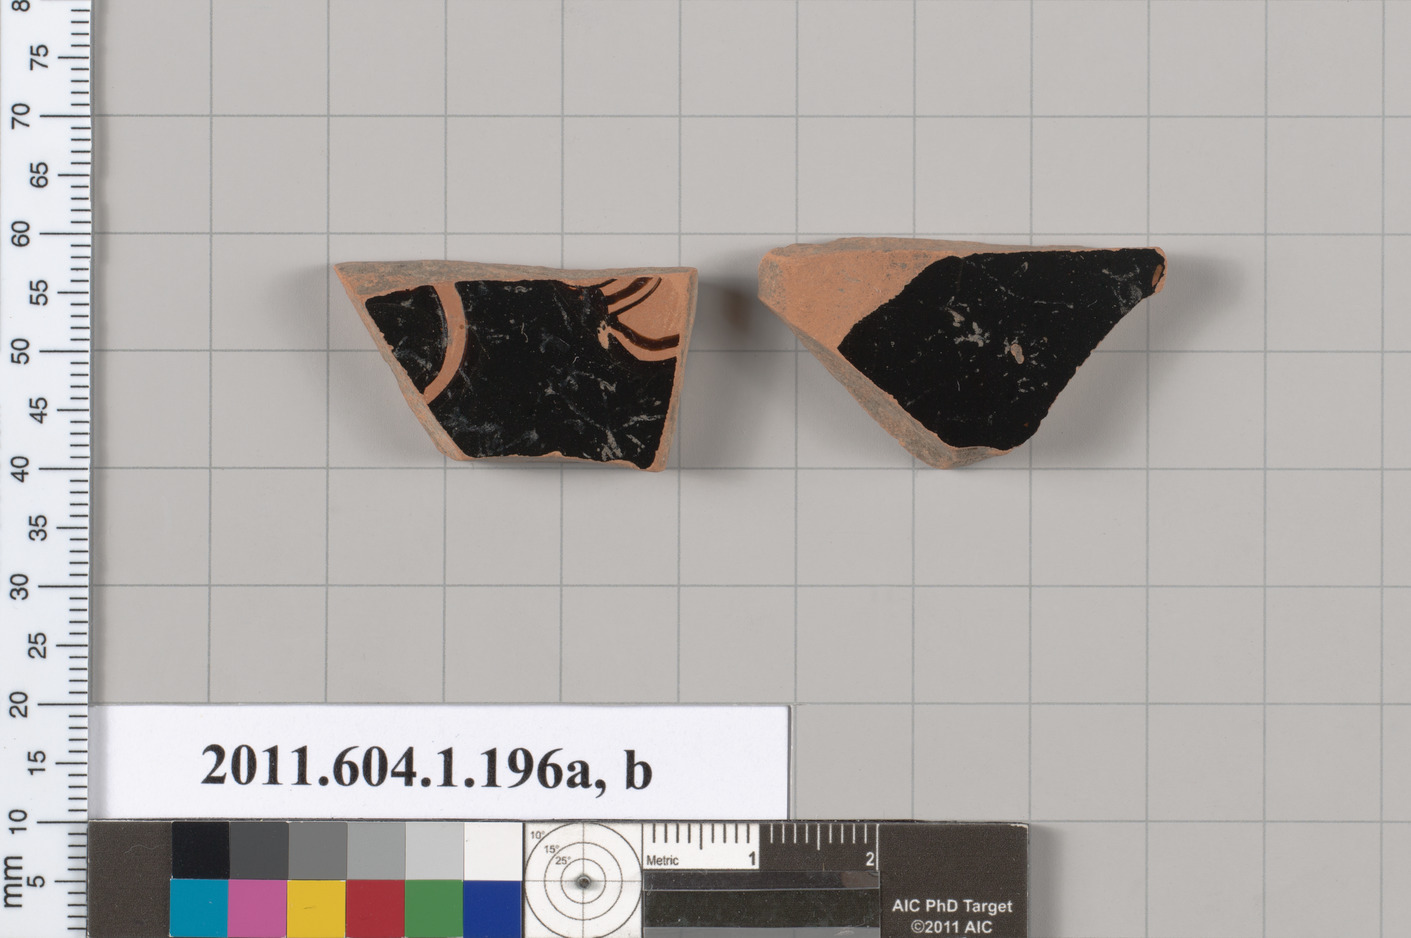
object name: kylix fragment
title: Terracotta fragments of a kylix (drinking cup)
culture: greek, attic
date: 475-451 BCE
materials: terracotta